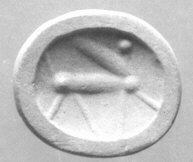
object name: stamp seal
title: Stamp seal (scaraboid with pointed top) with monster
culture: assyro-babylonian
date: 700-501 BCE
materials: stone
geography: mesopotamia